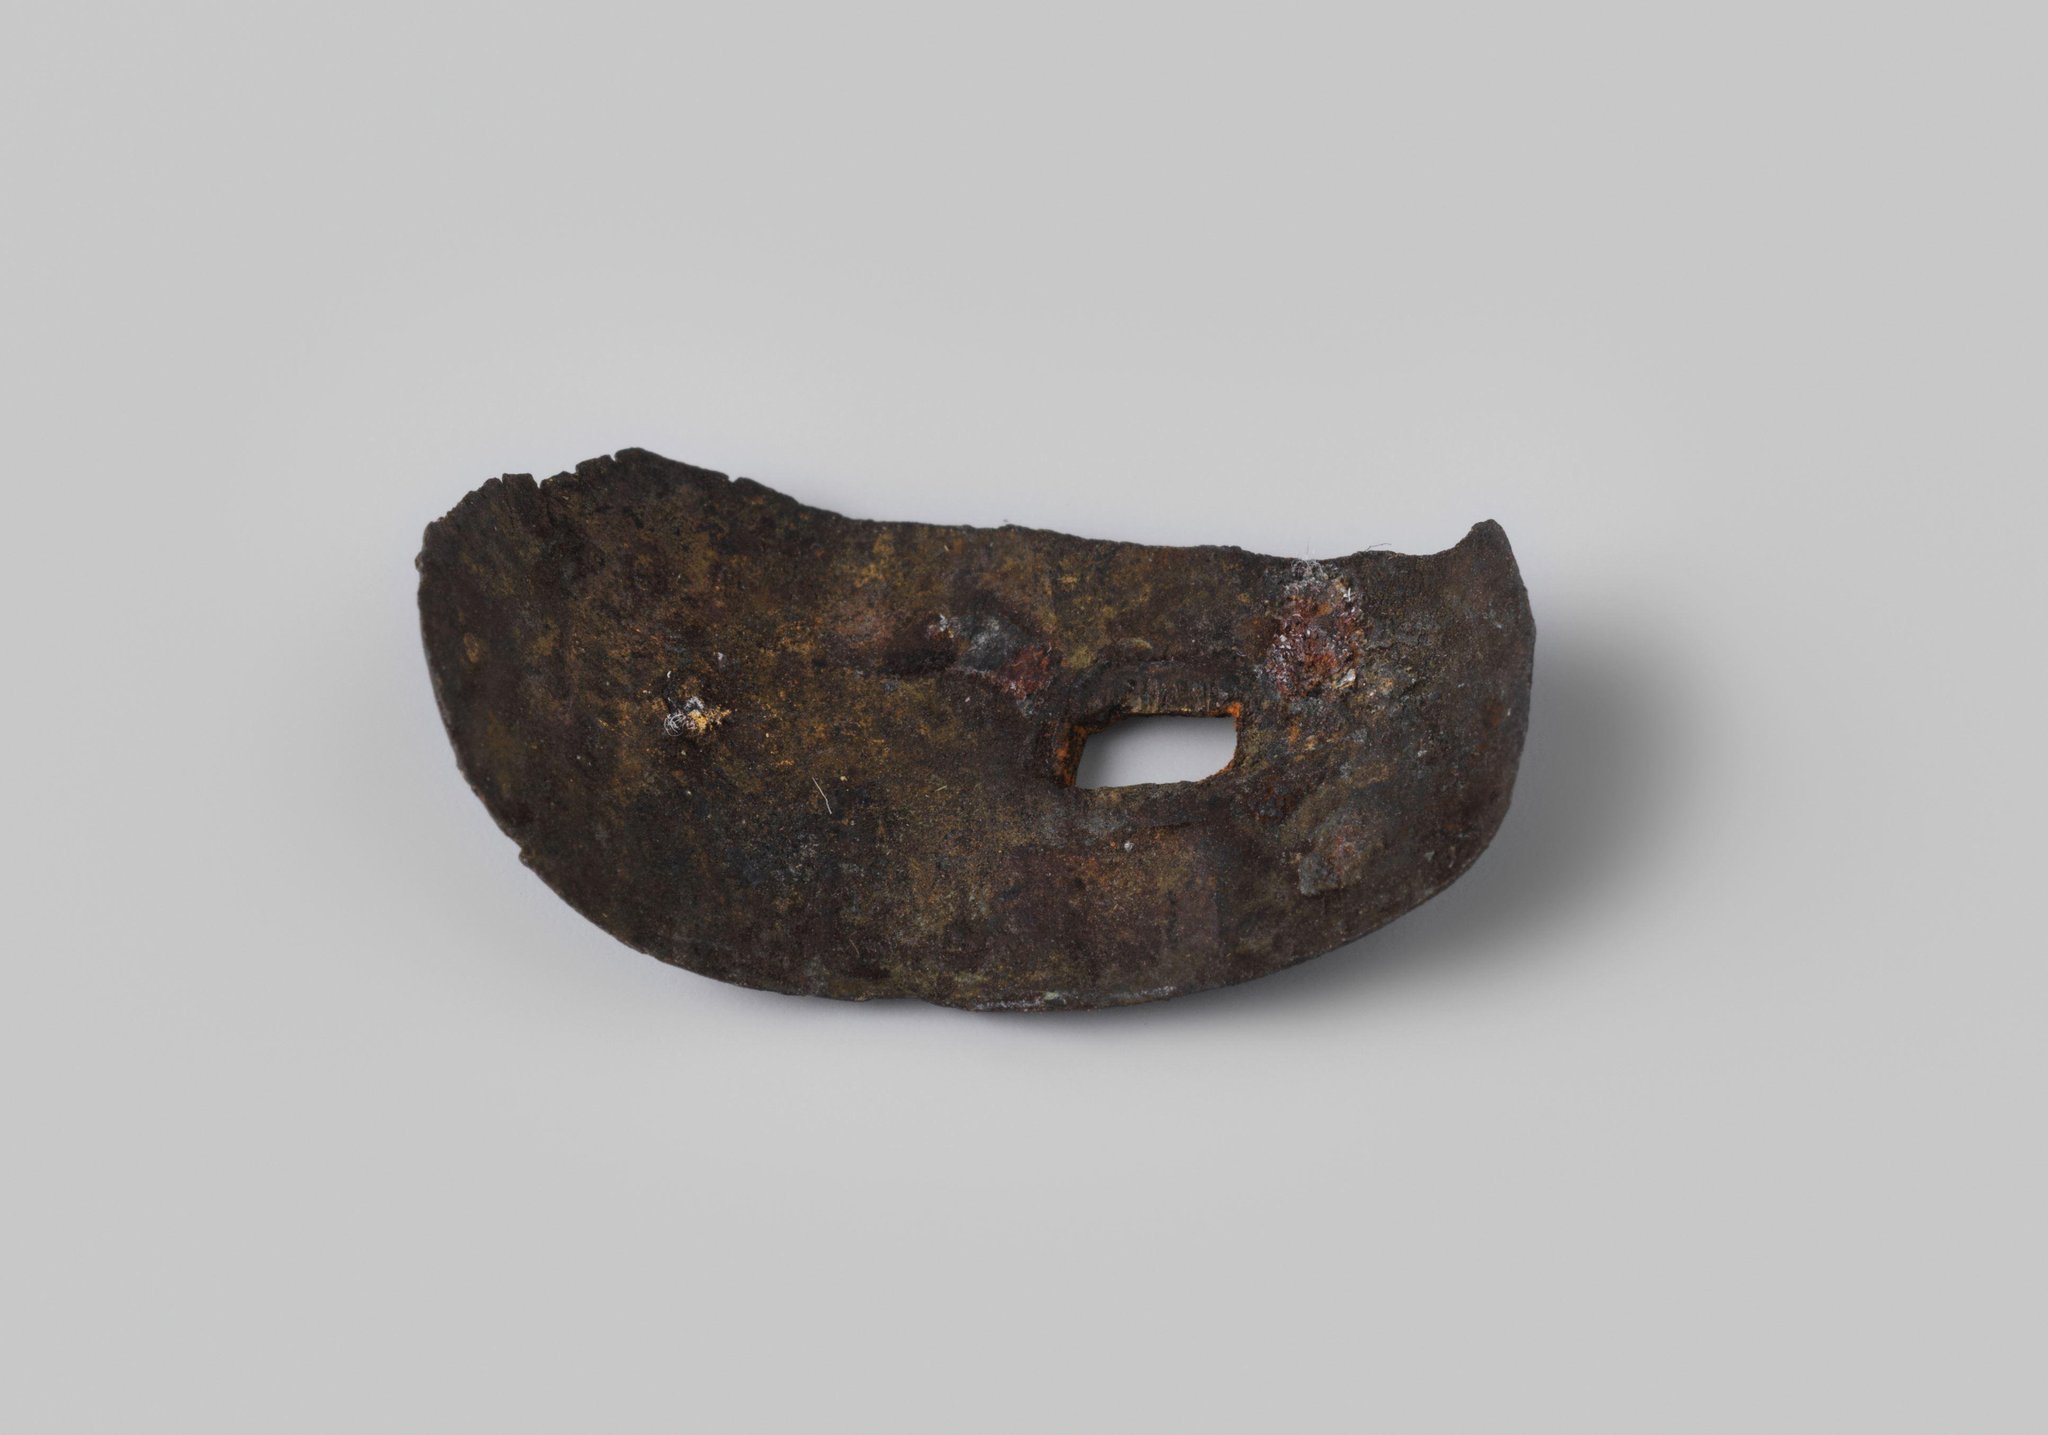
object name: sluitring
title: Fragment sluitring uit het wrak van de Oost-Indiëvaarder Hollandia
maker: Anonymous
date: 1700-1743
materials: copper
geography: netherlands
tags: verenigde oostindische compagnie, hollandia (schip), annet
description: Varied parts or fragments, washers; oval, curved, rectangular hole.